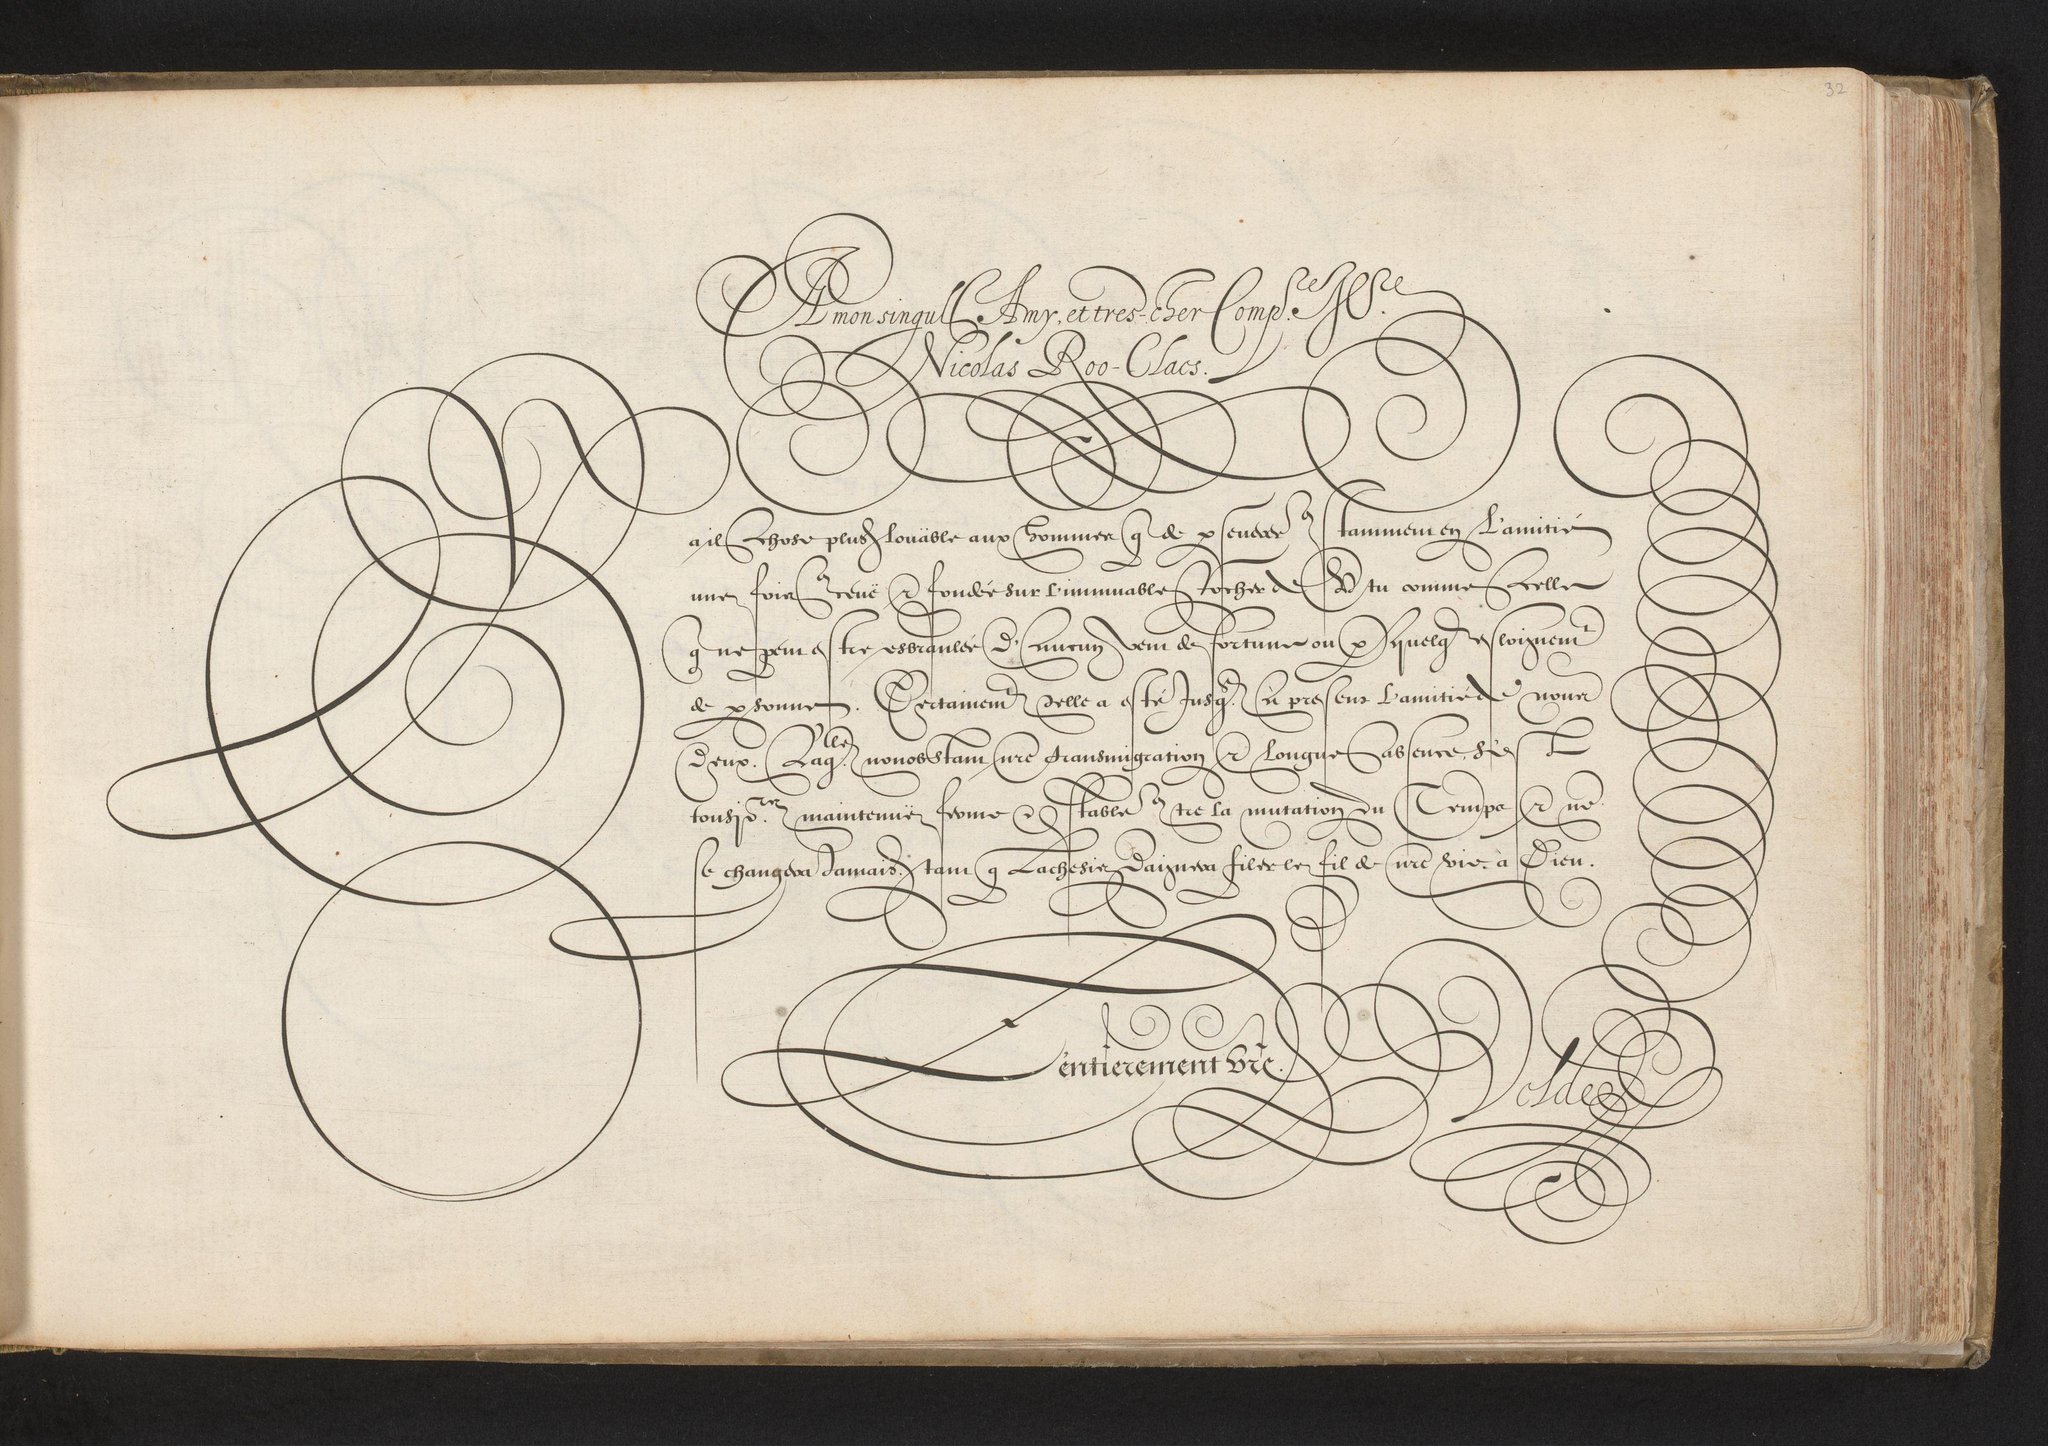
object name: ornament print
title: Spieghel der schrijfkonste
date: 1605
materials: paper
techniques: engraving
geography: rotterdam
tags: calligraphy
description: Schrijfvoorbeeld met de aanhef: A mon singul[ier] amy, et tres-cher comp[frere] Ill[ustre] Nicolas Roo-Claes. Daaronder in een andere letter een initiaal Y en zeven regels tekst in het Frans: Y a il chose ... De tekst is omlijst door krulwerk. De prent maakt deel uit van een album.